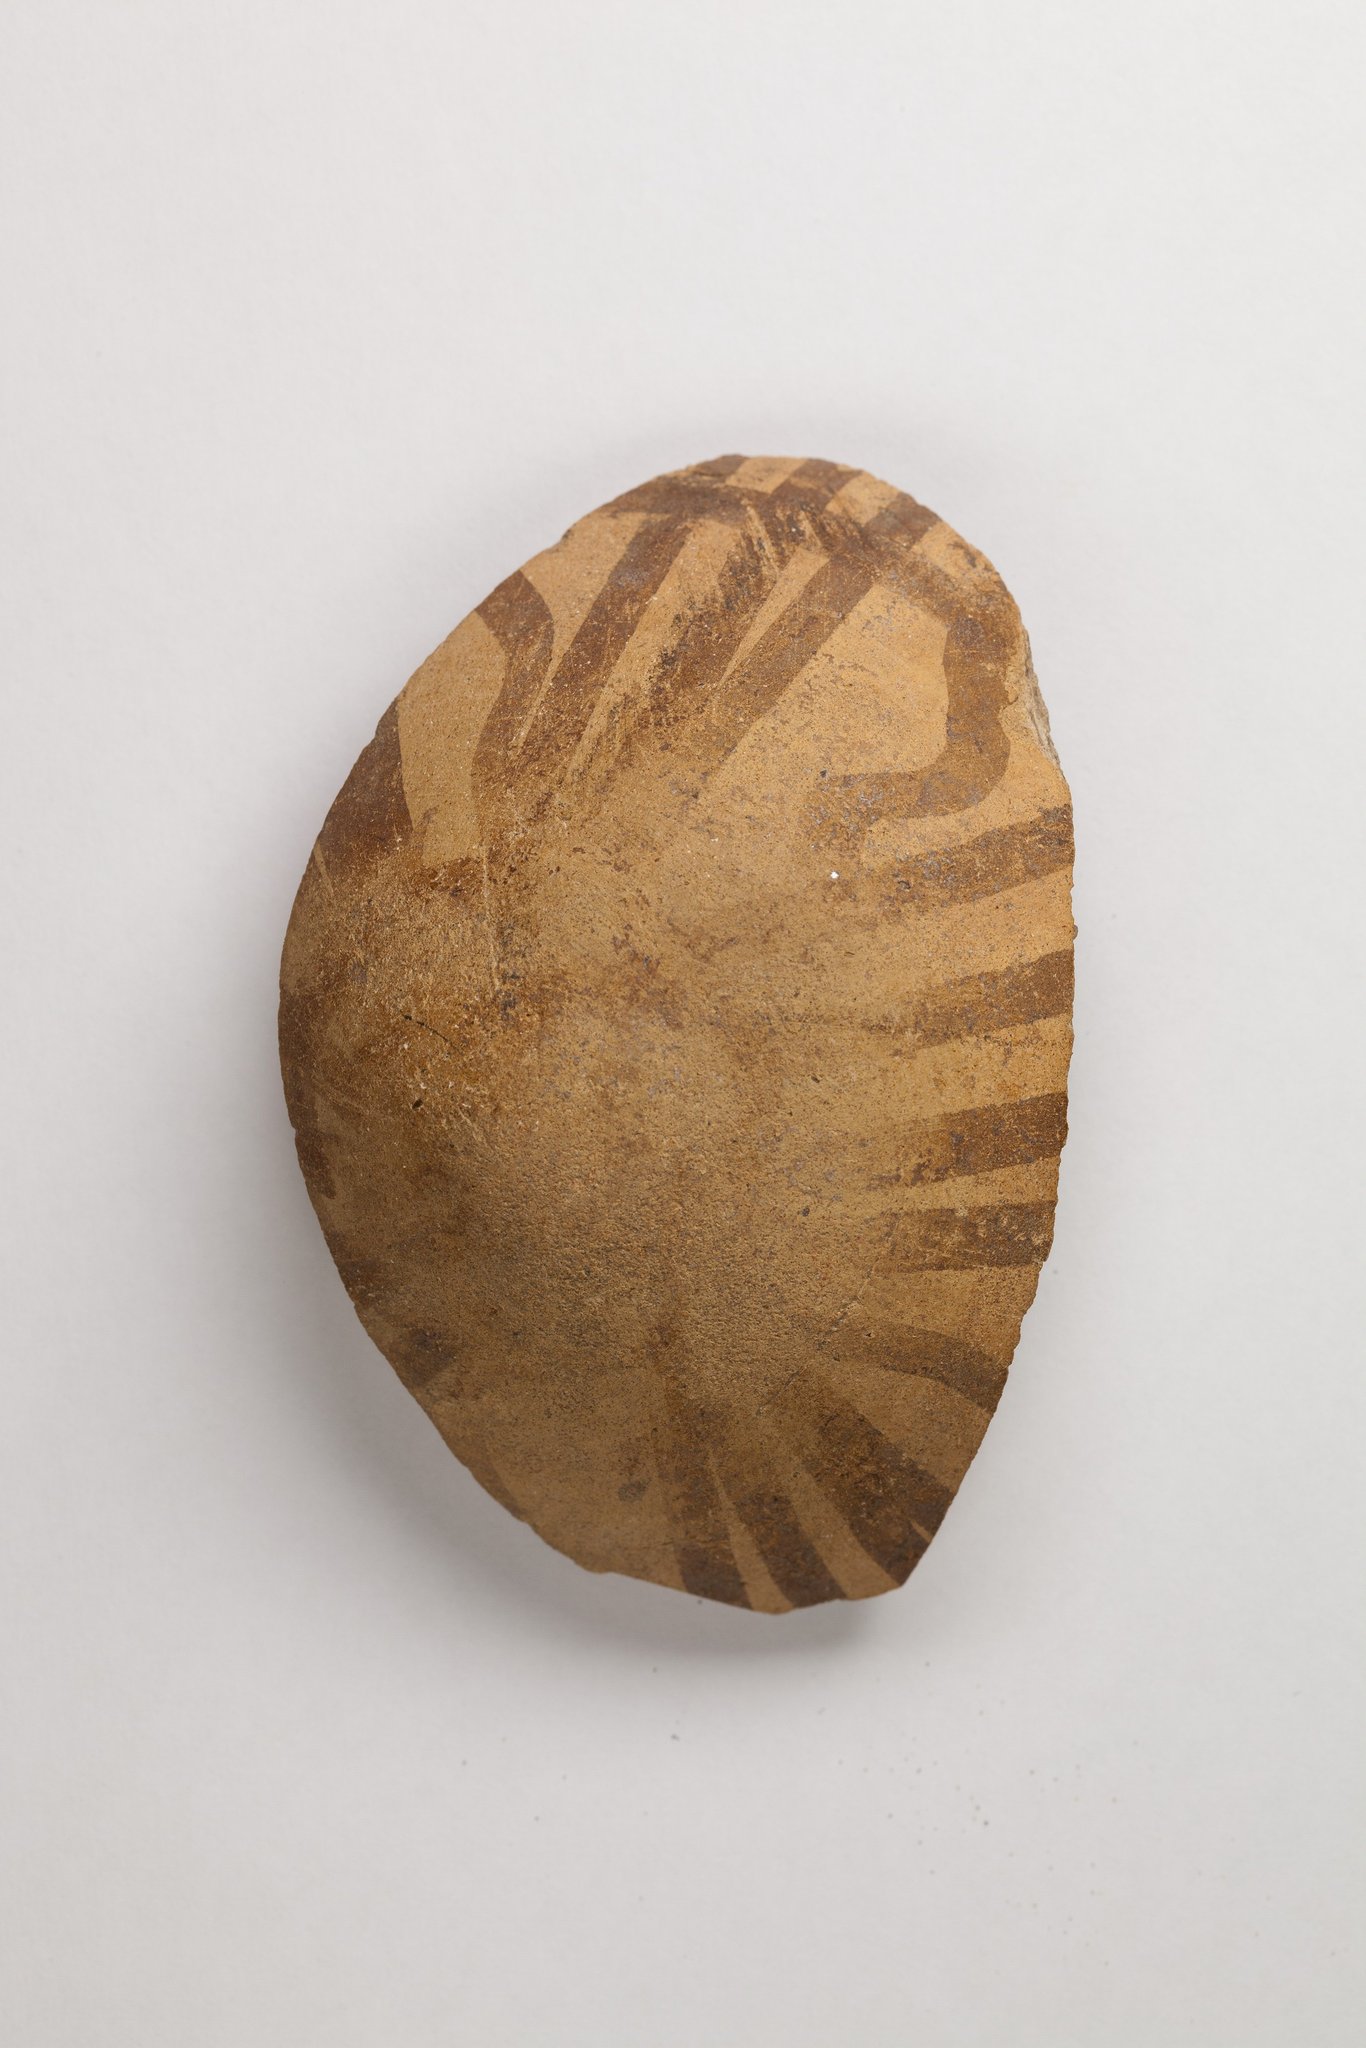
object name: base, round bottomed cypriot juglet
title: Base of round bottomed Cypriot juglet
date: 1981-1640 BCE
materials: pottery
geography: egypt